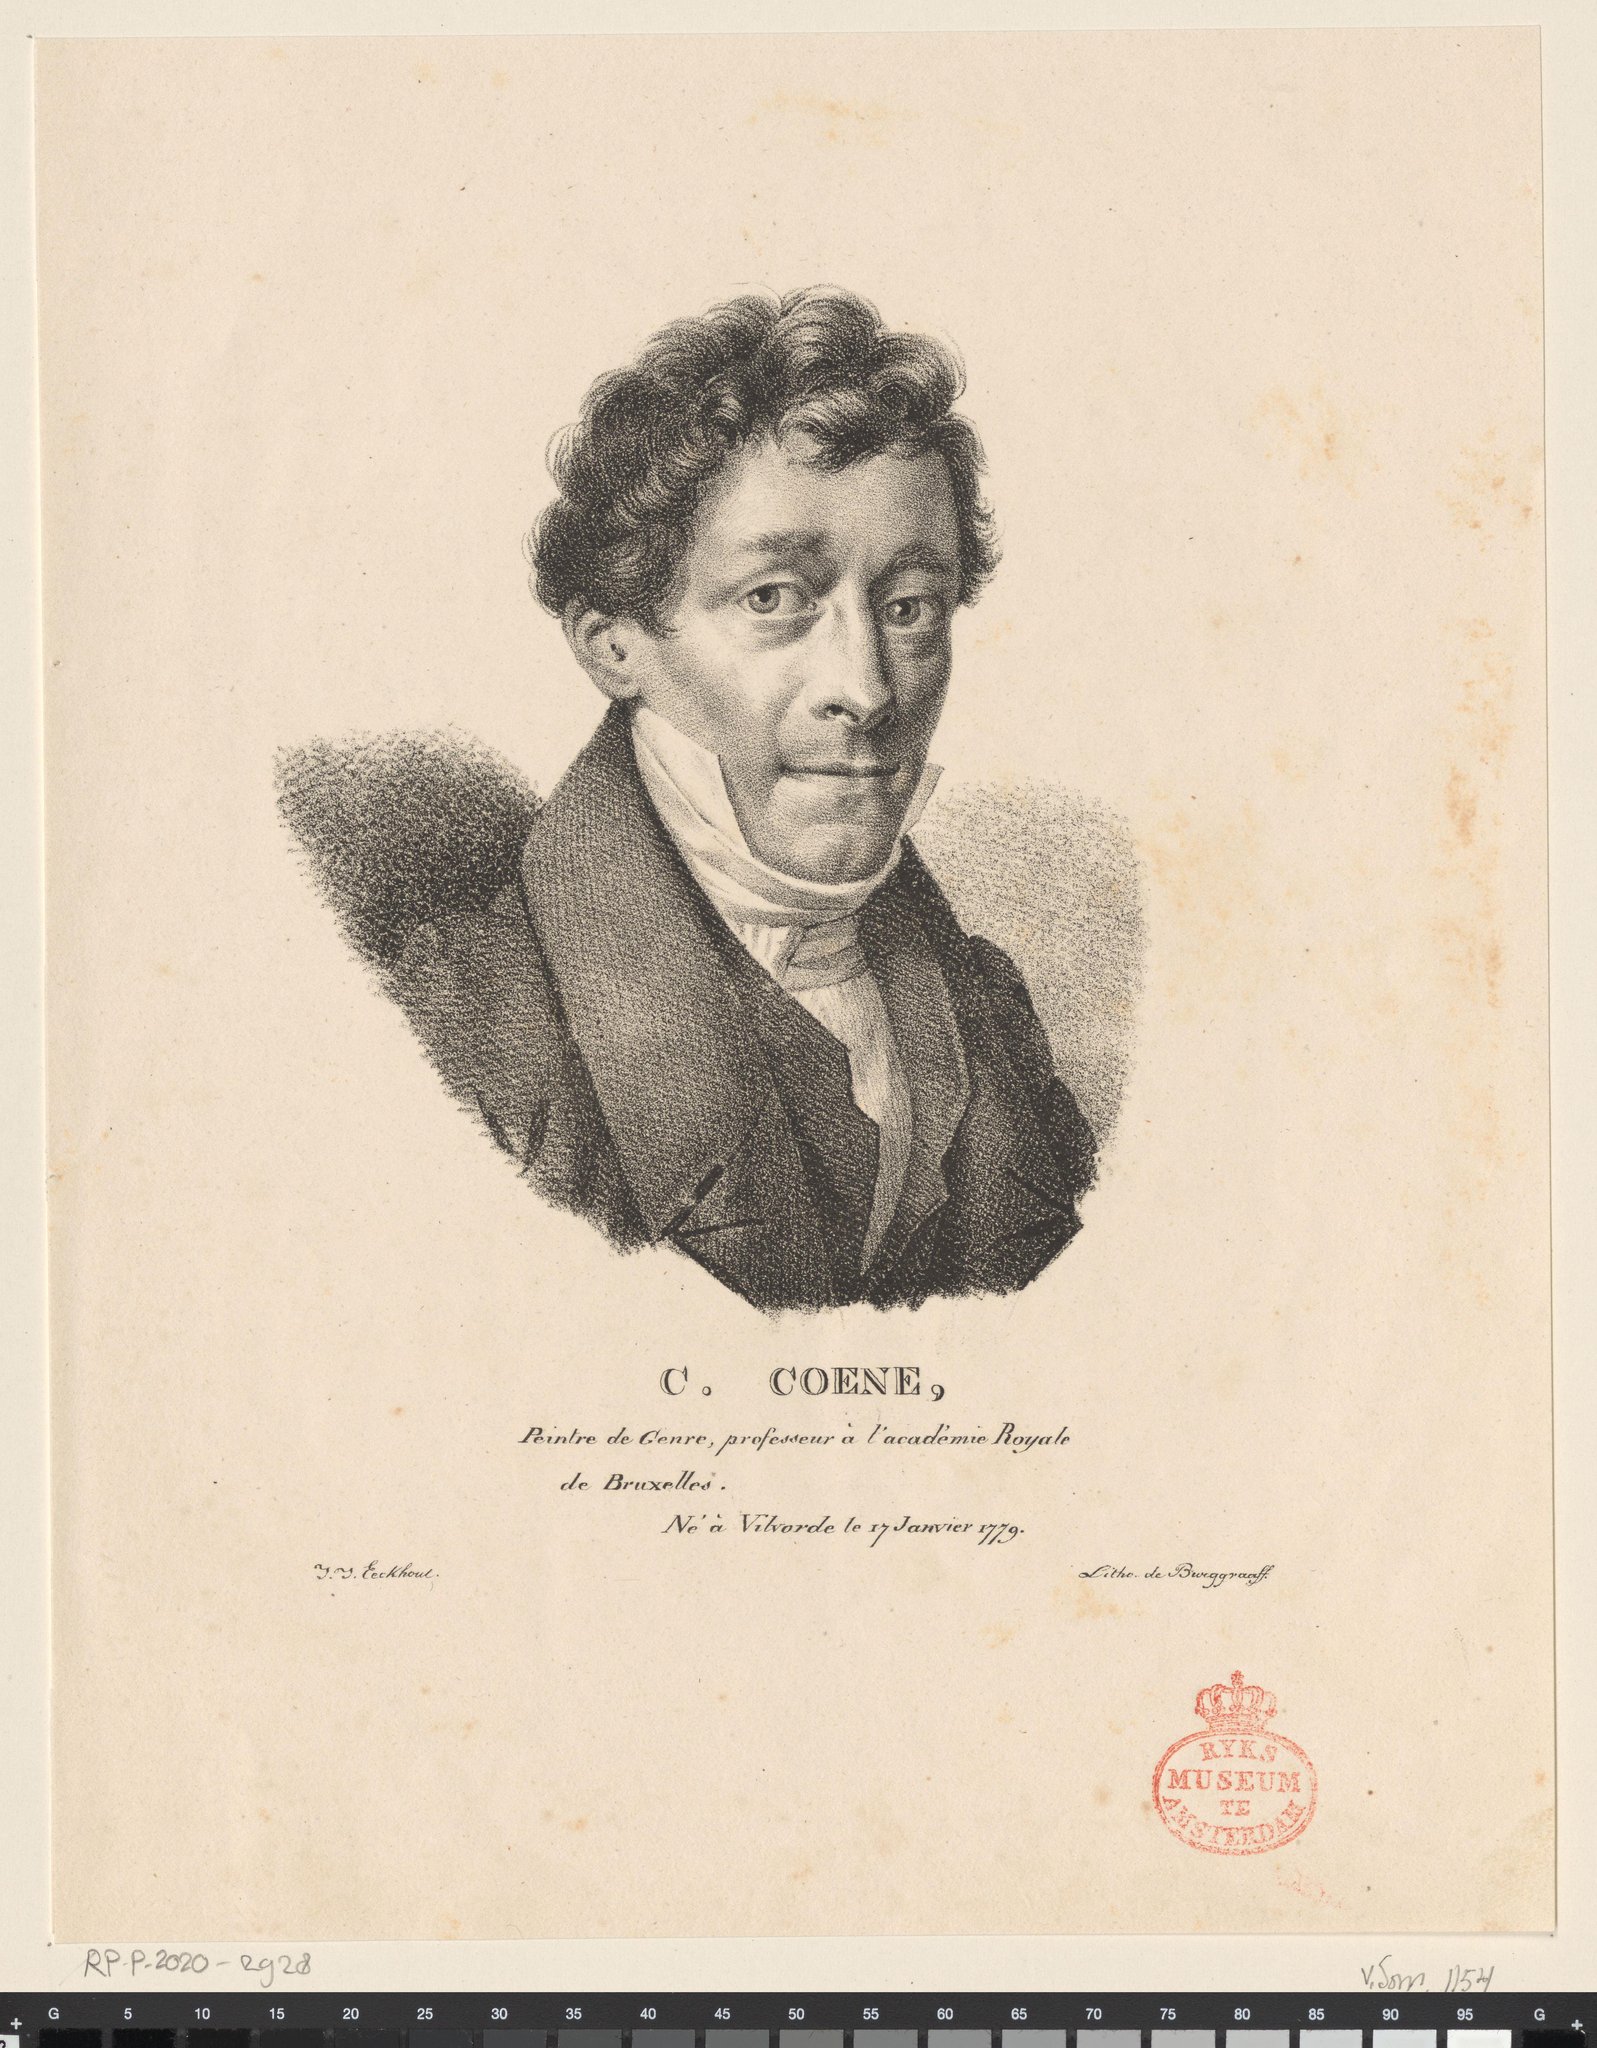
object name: print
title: Portraits des artistes modernes nés dans le Royaume des Pays-Bas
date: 1822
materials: paper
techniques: lithograph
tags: brussels, draughtsman, constantinus fidelio coene, historical persons, portrait, self-portrait of painter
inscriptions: collector's mark: Lugt 12